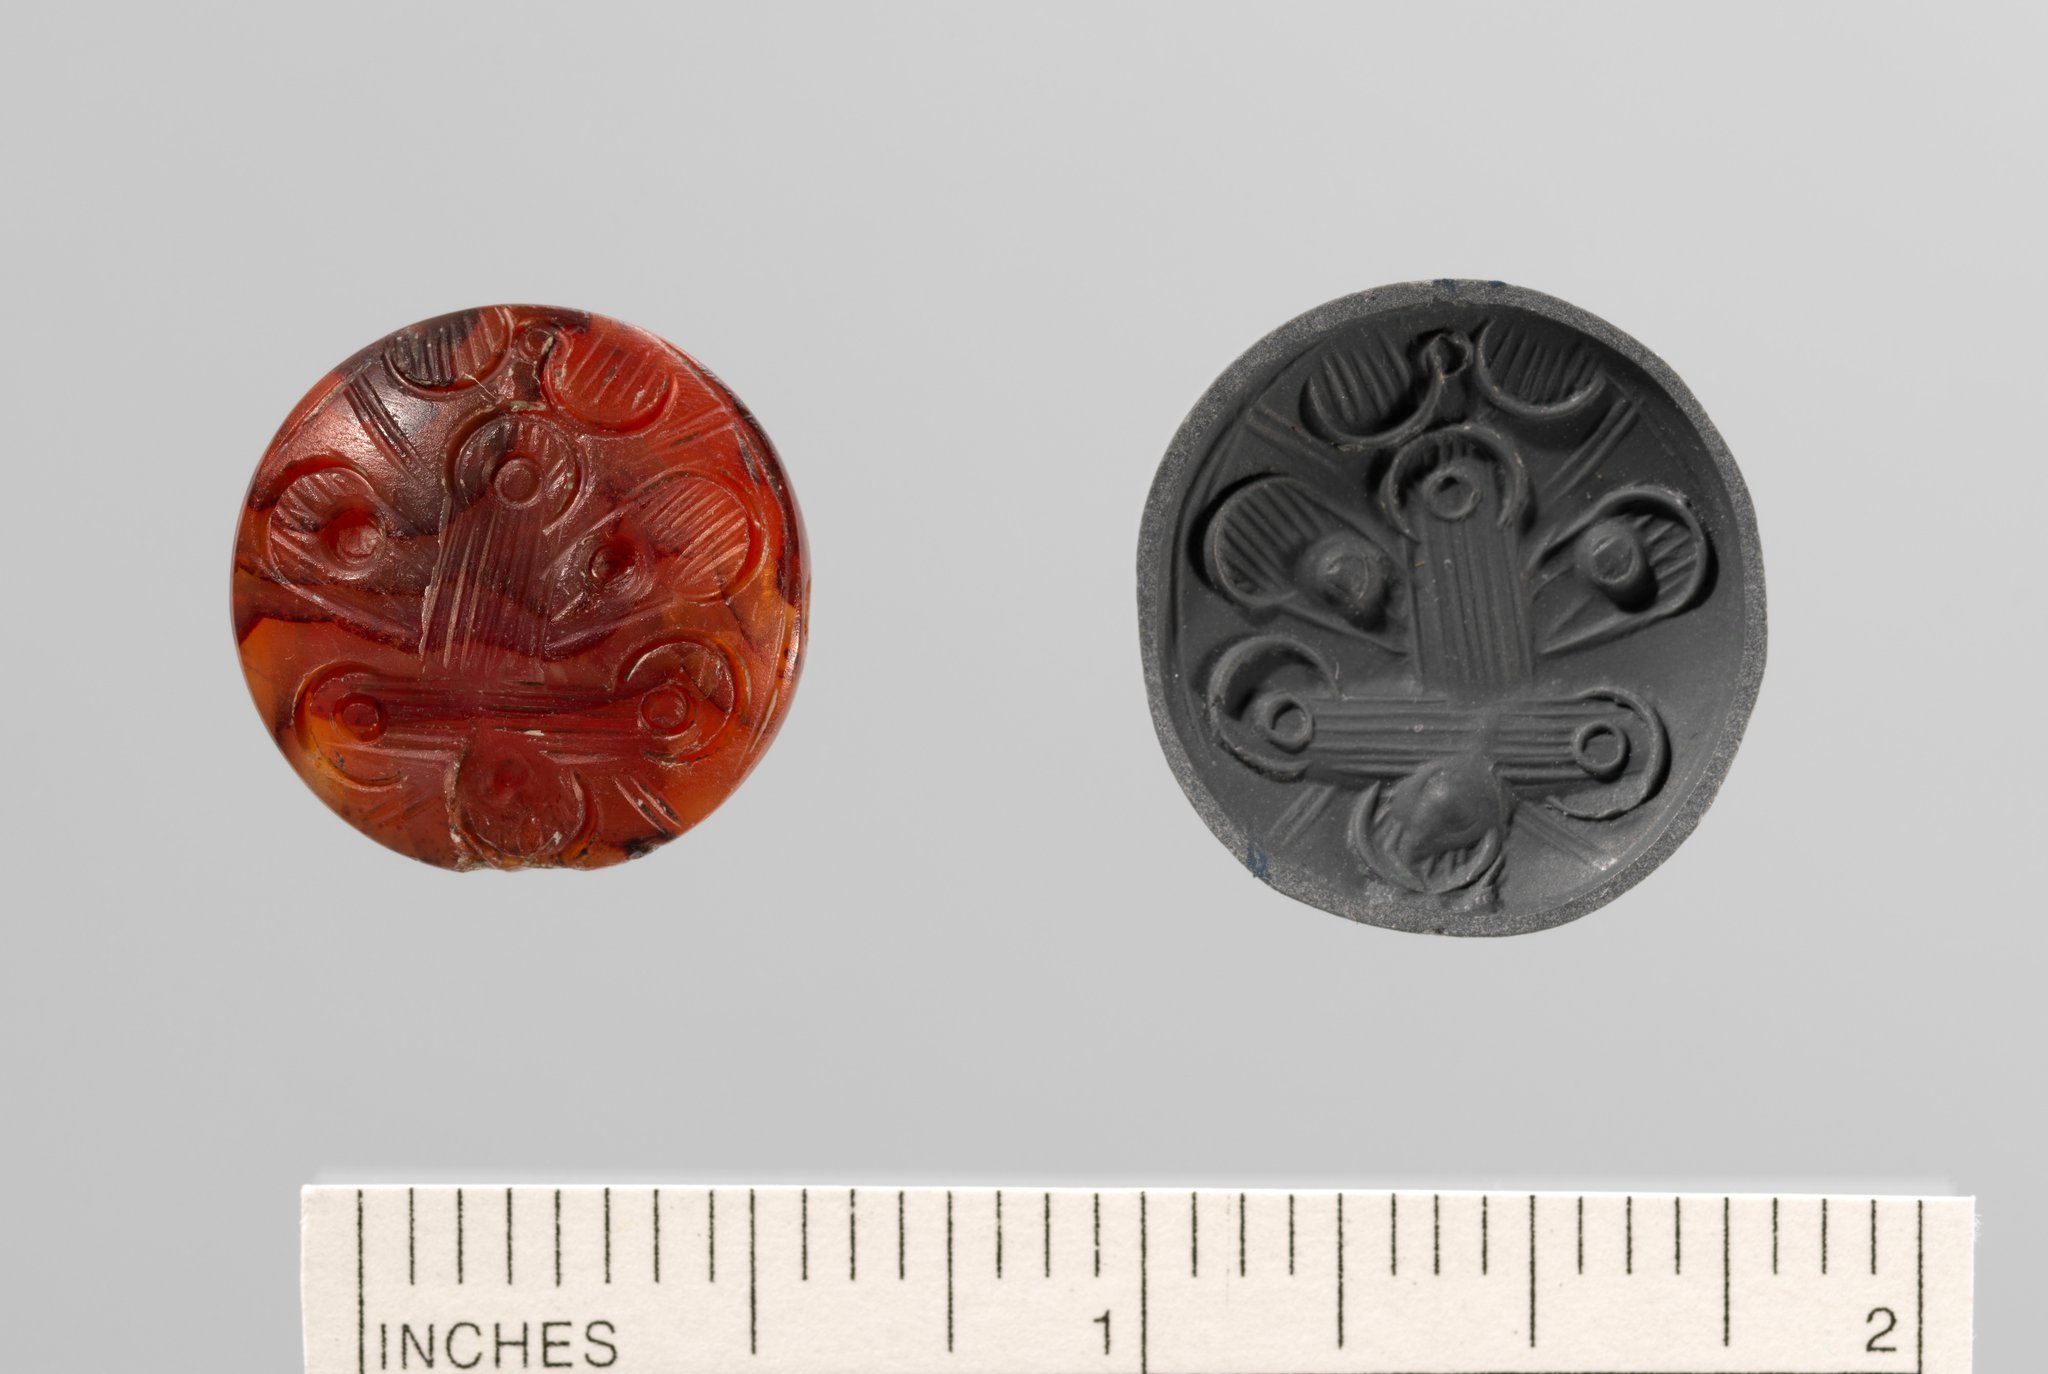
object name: seal, lentoid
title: Carnelian Lentoid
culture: minoan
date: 1600-1450 BCE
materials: gemstone